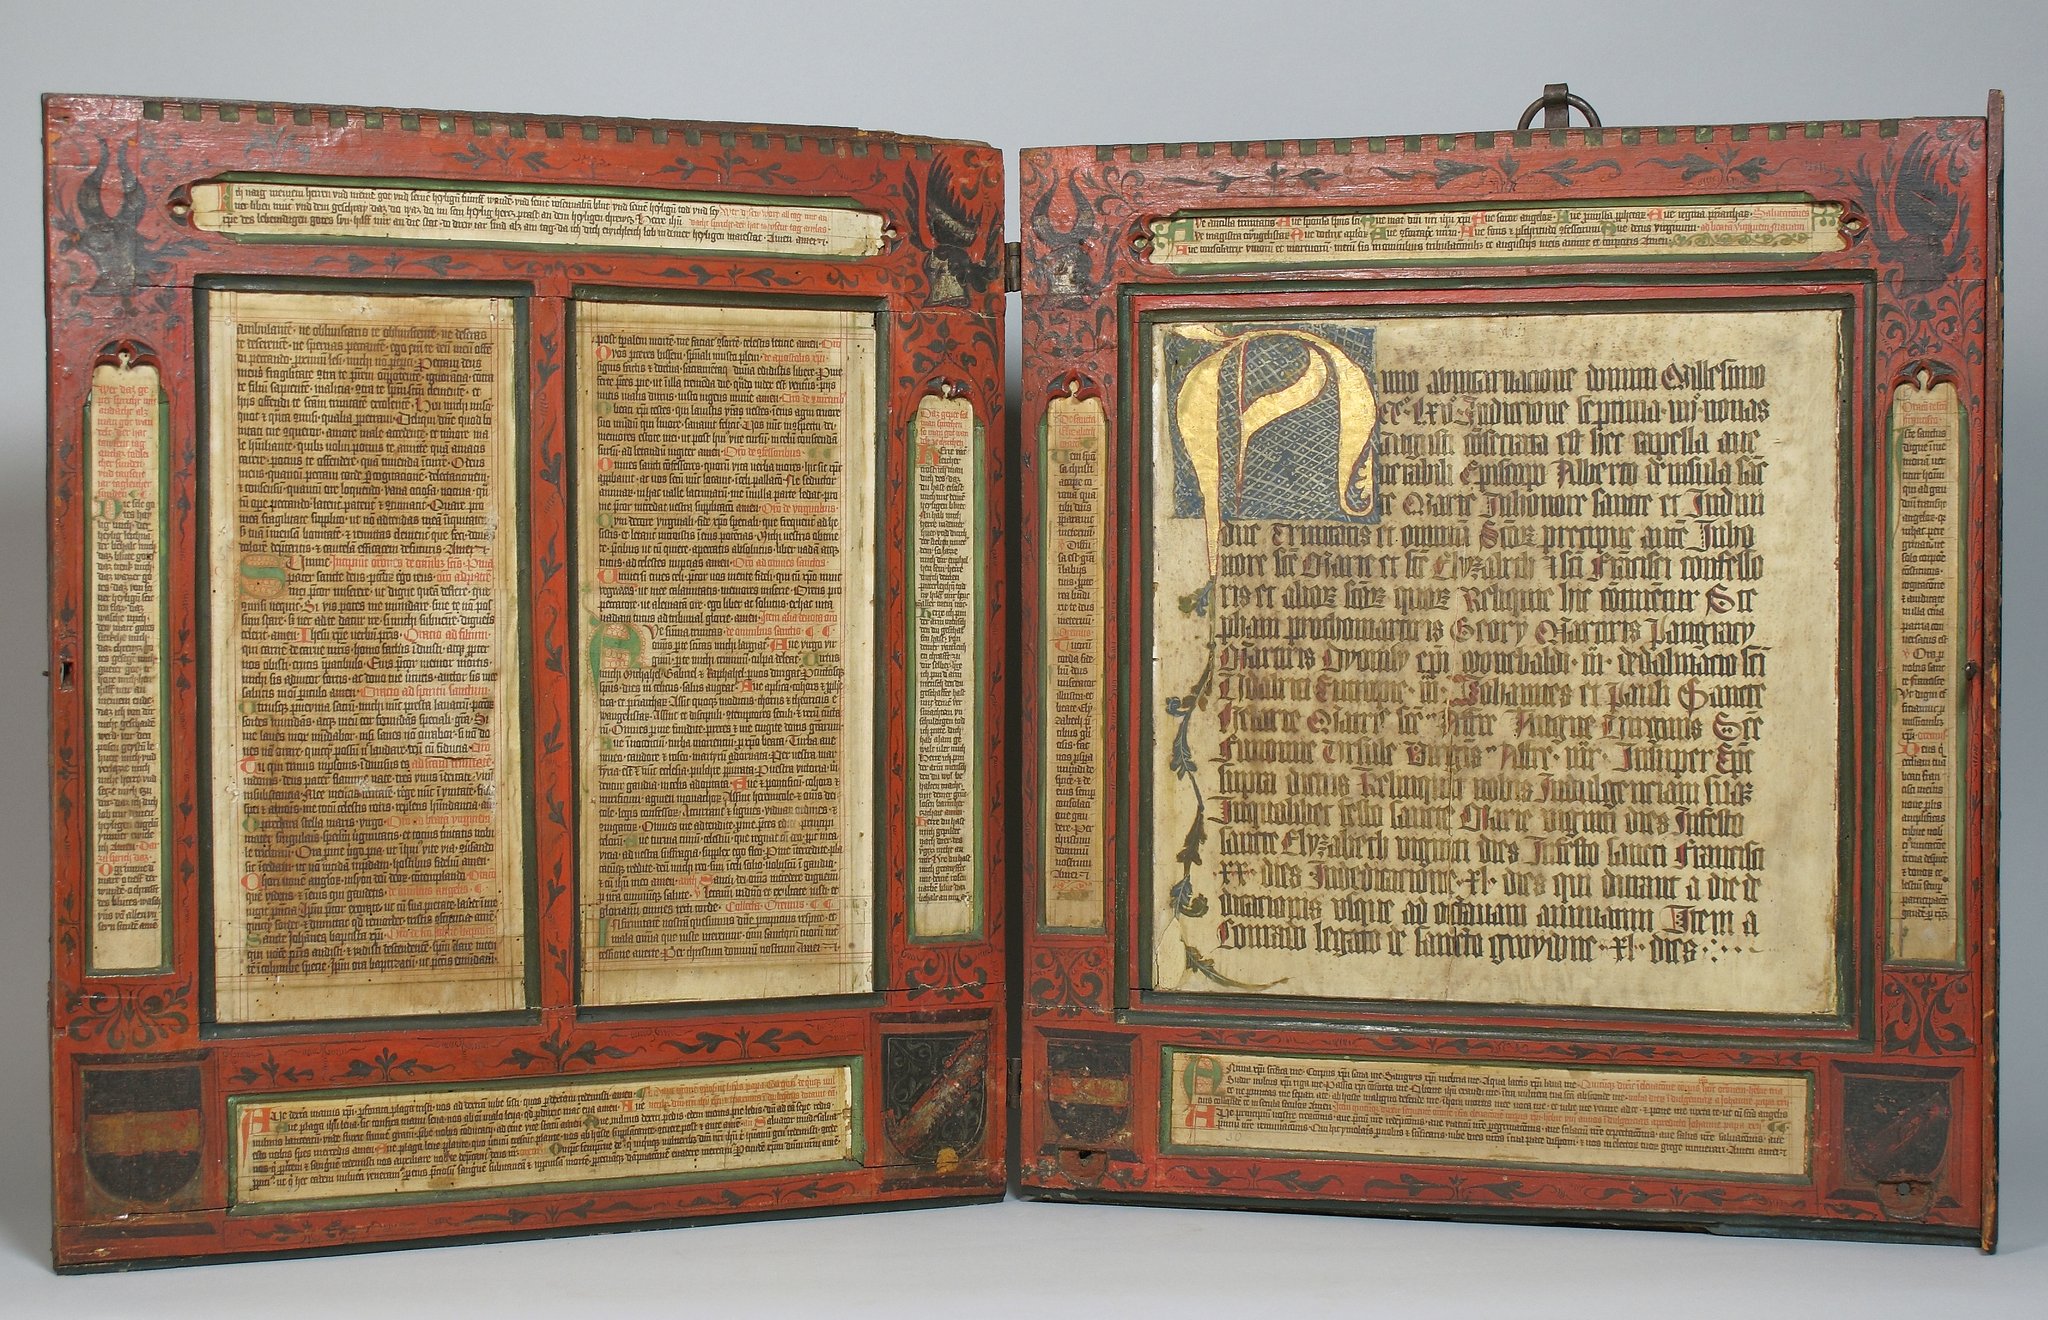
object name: diptych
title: Devotional Diptych with inset Manuscript Texts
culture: austrian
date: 1401-1500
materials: ink, paper, parchment, pigment, wood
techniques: polychrome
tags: coat of arms